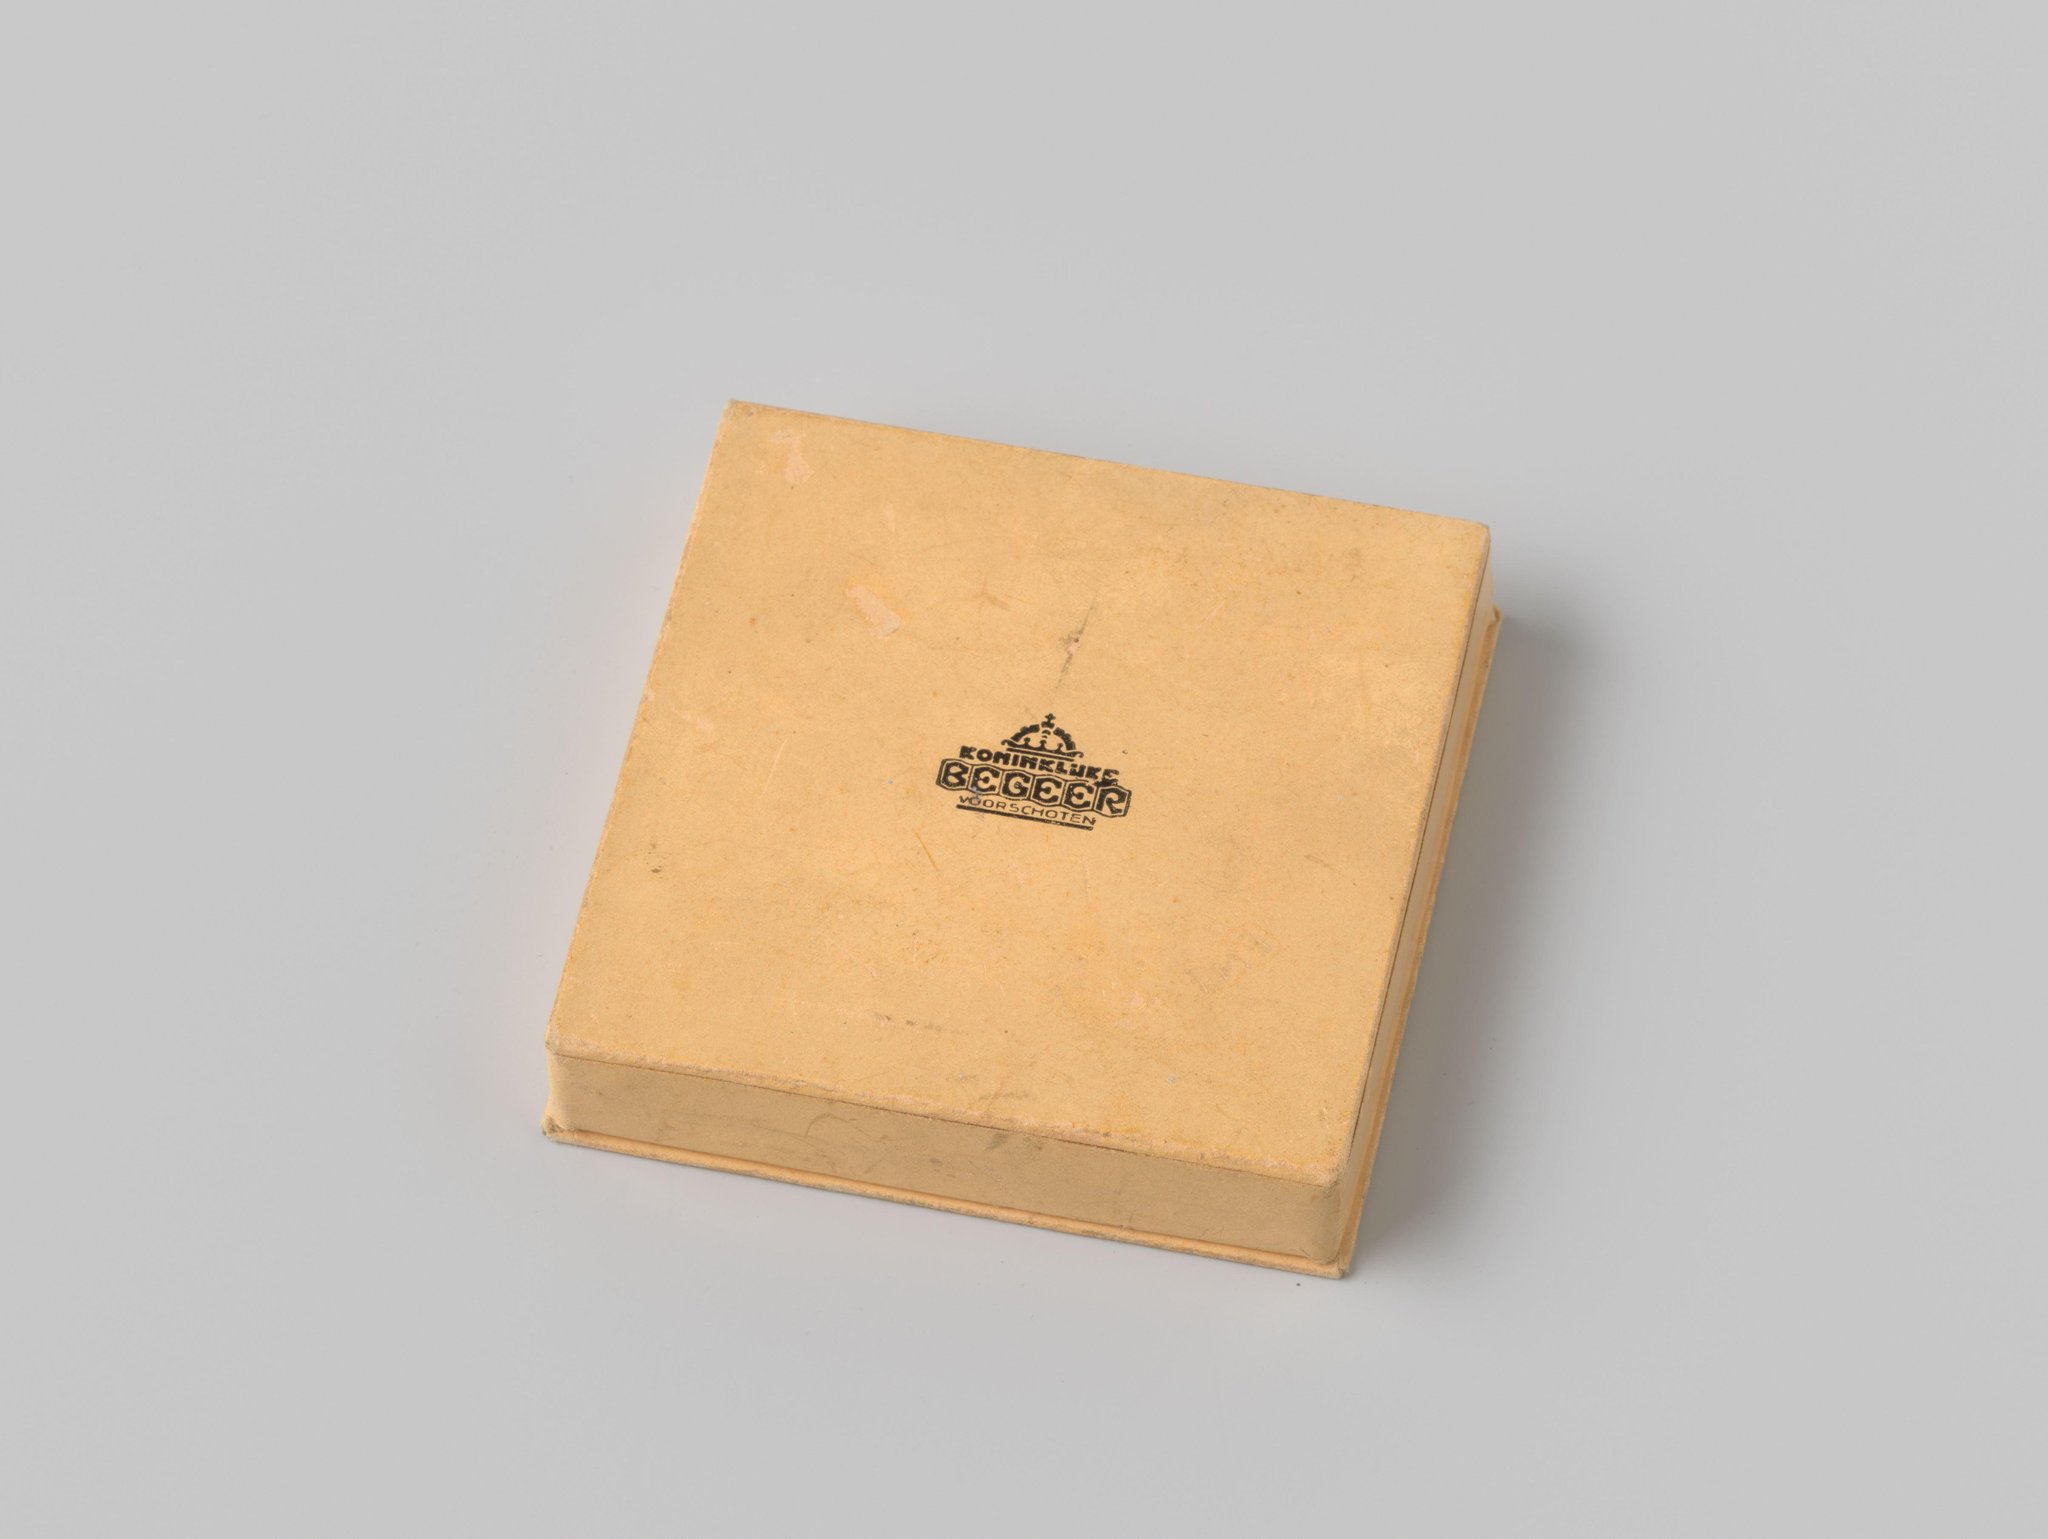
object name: box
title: Geel vierkant doosje van de Koninklijke Begeer Voorschoten behorend bij de penning Landbouw in Nederlands-Indië (Vereniging voor Penningkunst 1933, tweede penning)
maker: h.a. van derse ende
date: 1933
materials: cardboard, velvet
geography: voorschoten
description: Geel vierkant doosje uitgegeven doos de Koninklijke Begeer Voorschoten, behorende bij een bronzen penning.